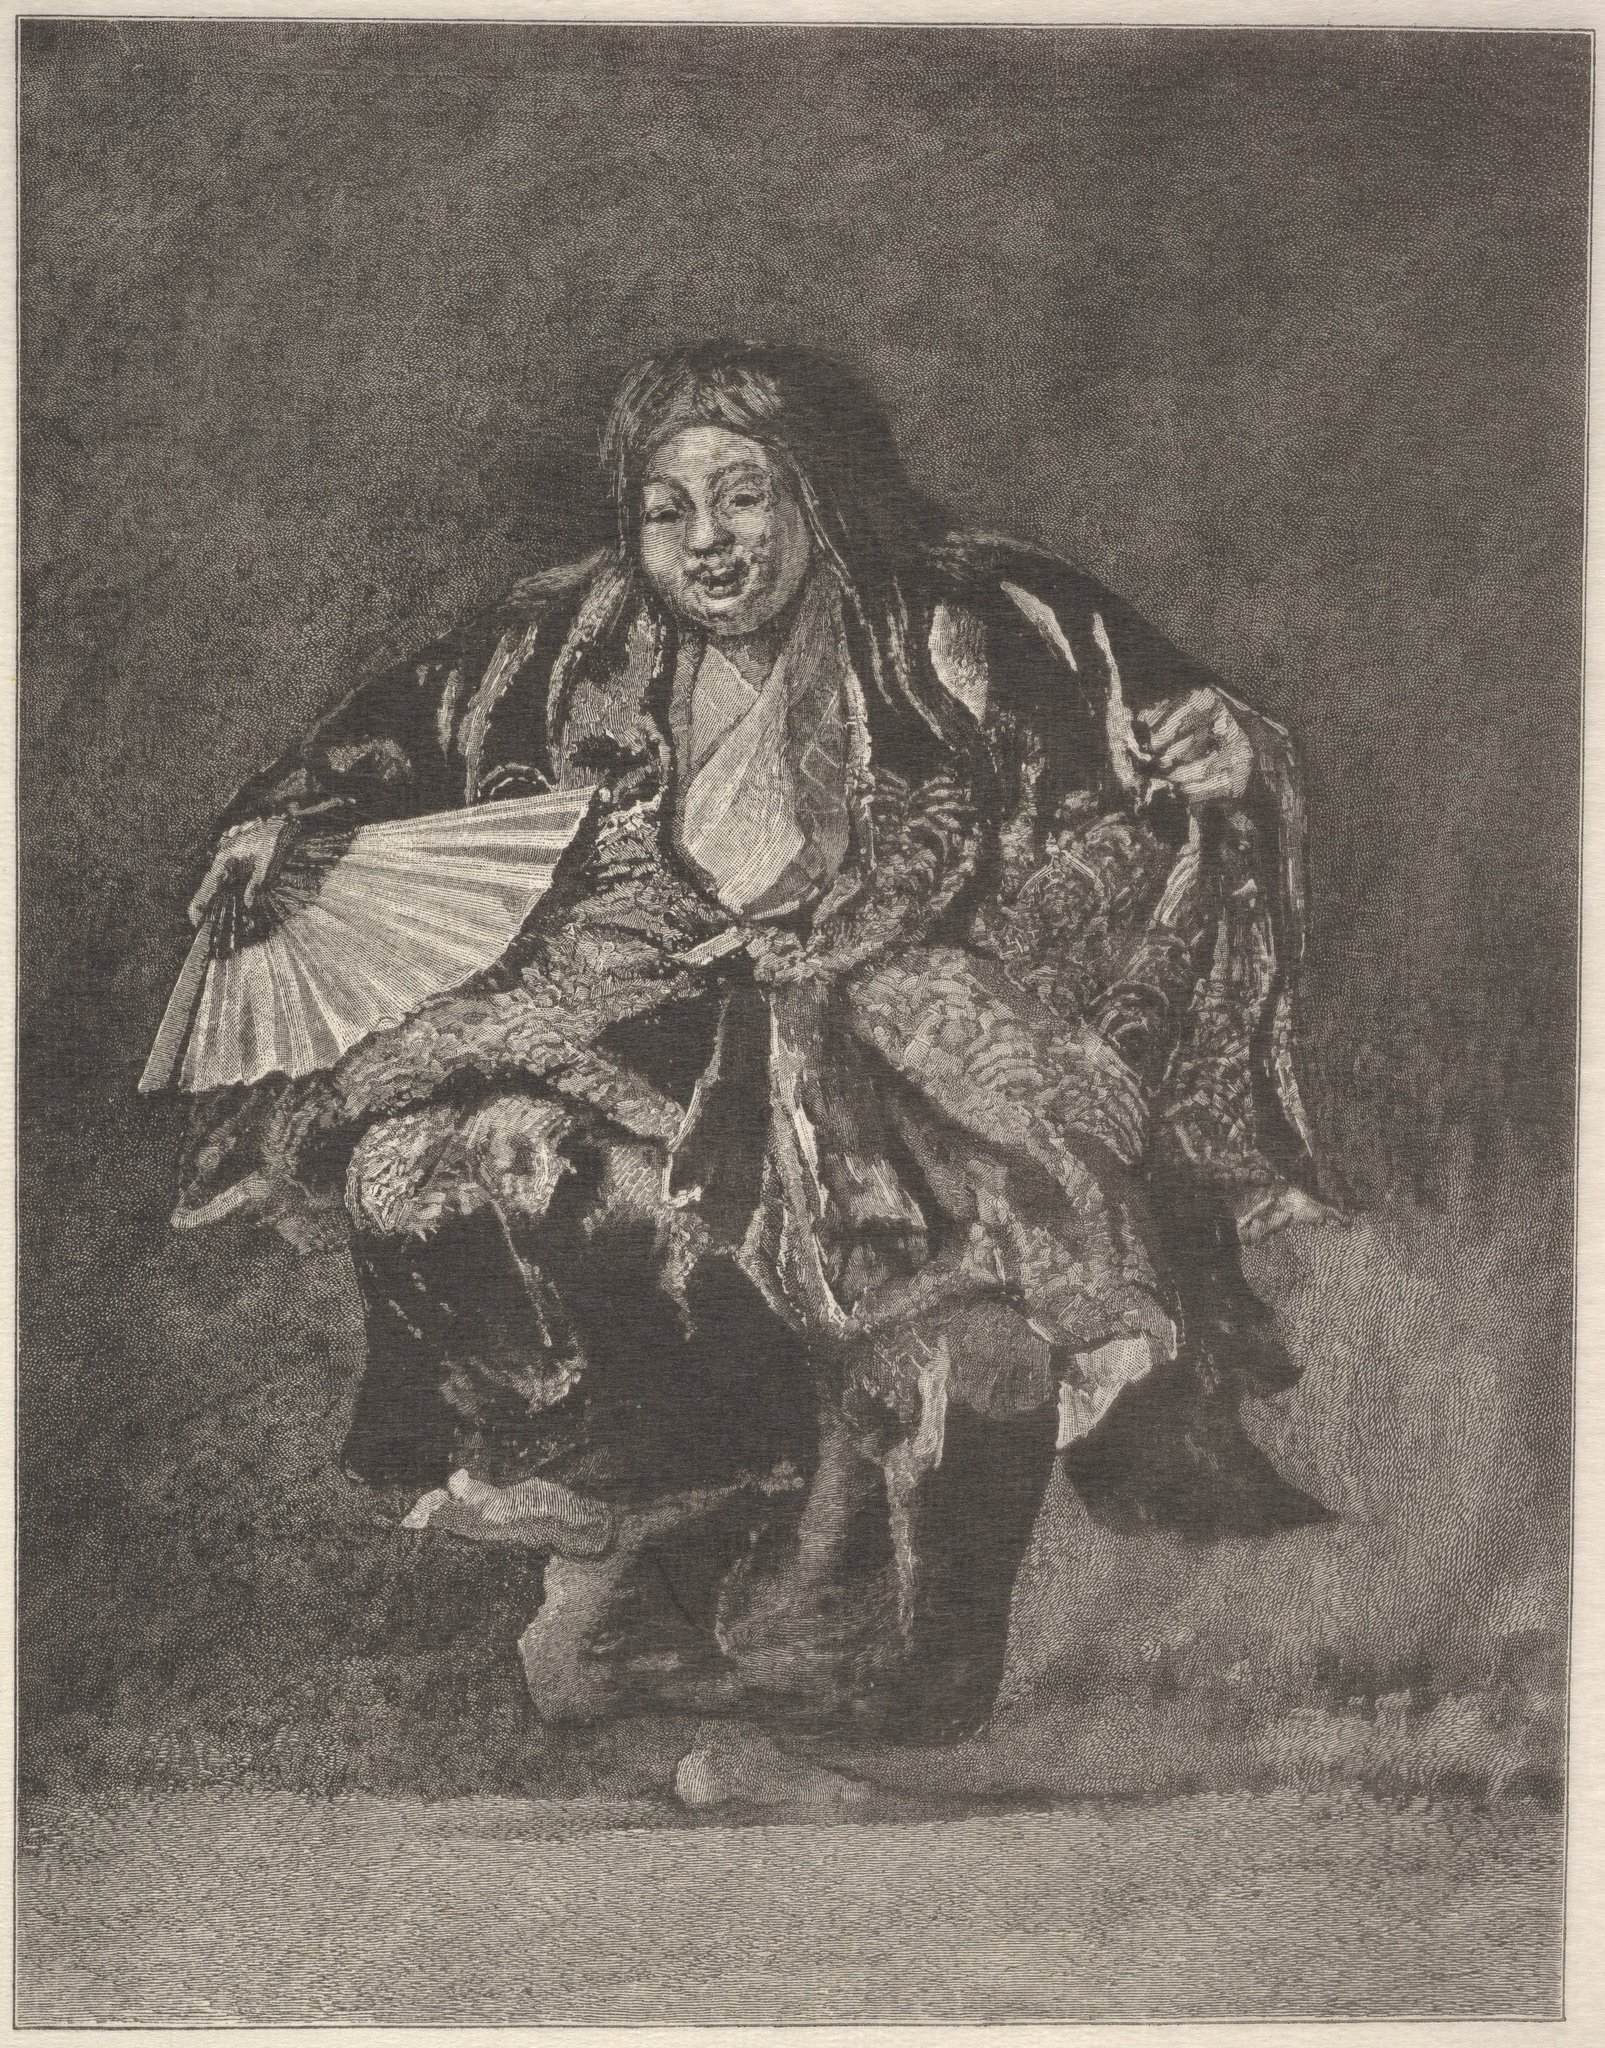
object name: print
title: Noh Dancer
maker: john la farge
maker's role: artist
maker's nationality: american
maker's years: 1835-1910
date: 1886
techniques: engraving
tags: human figures,fans,dancing,dancers